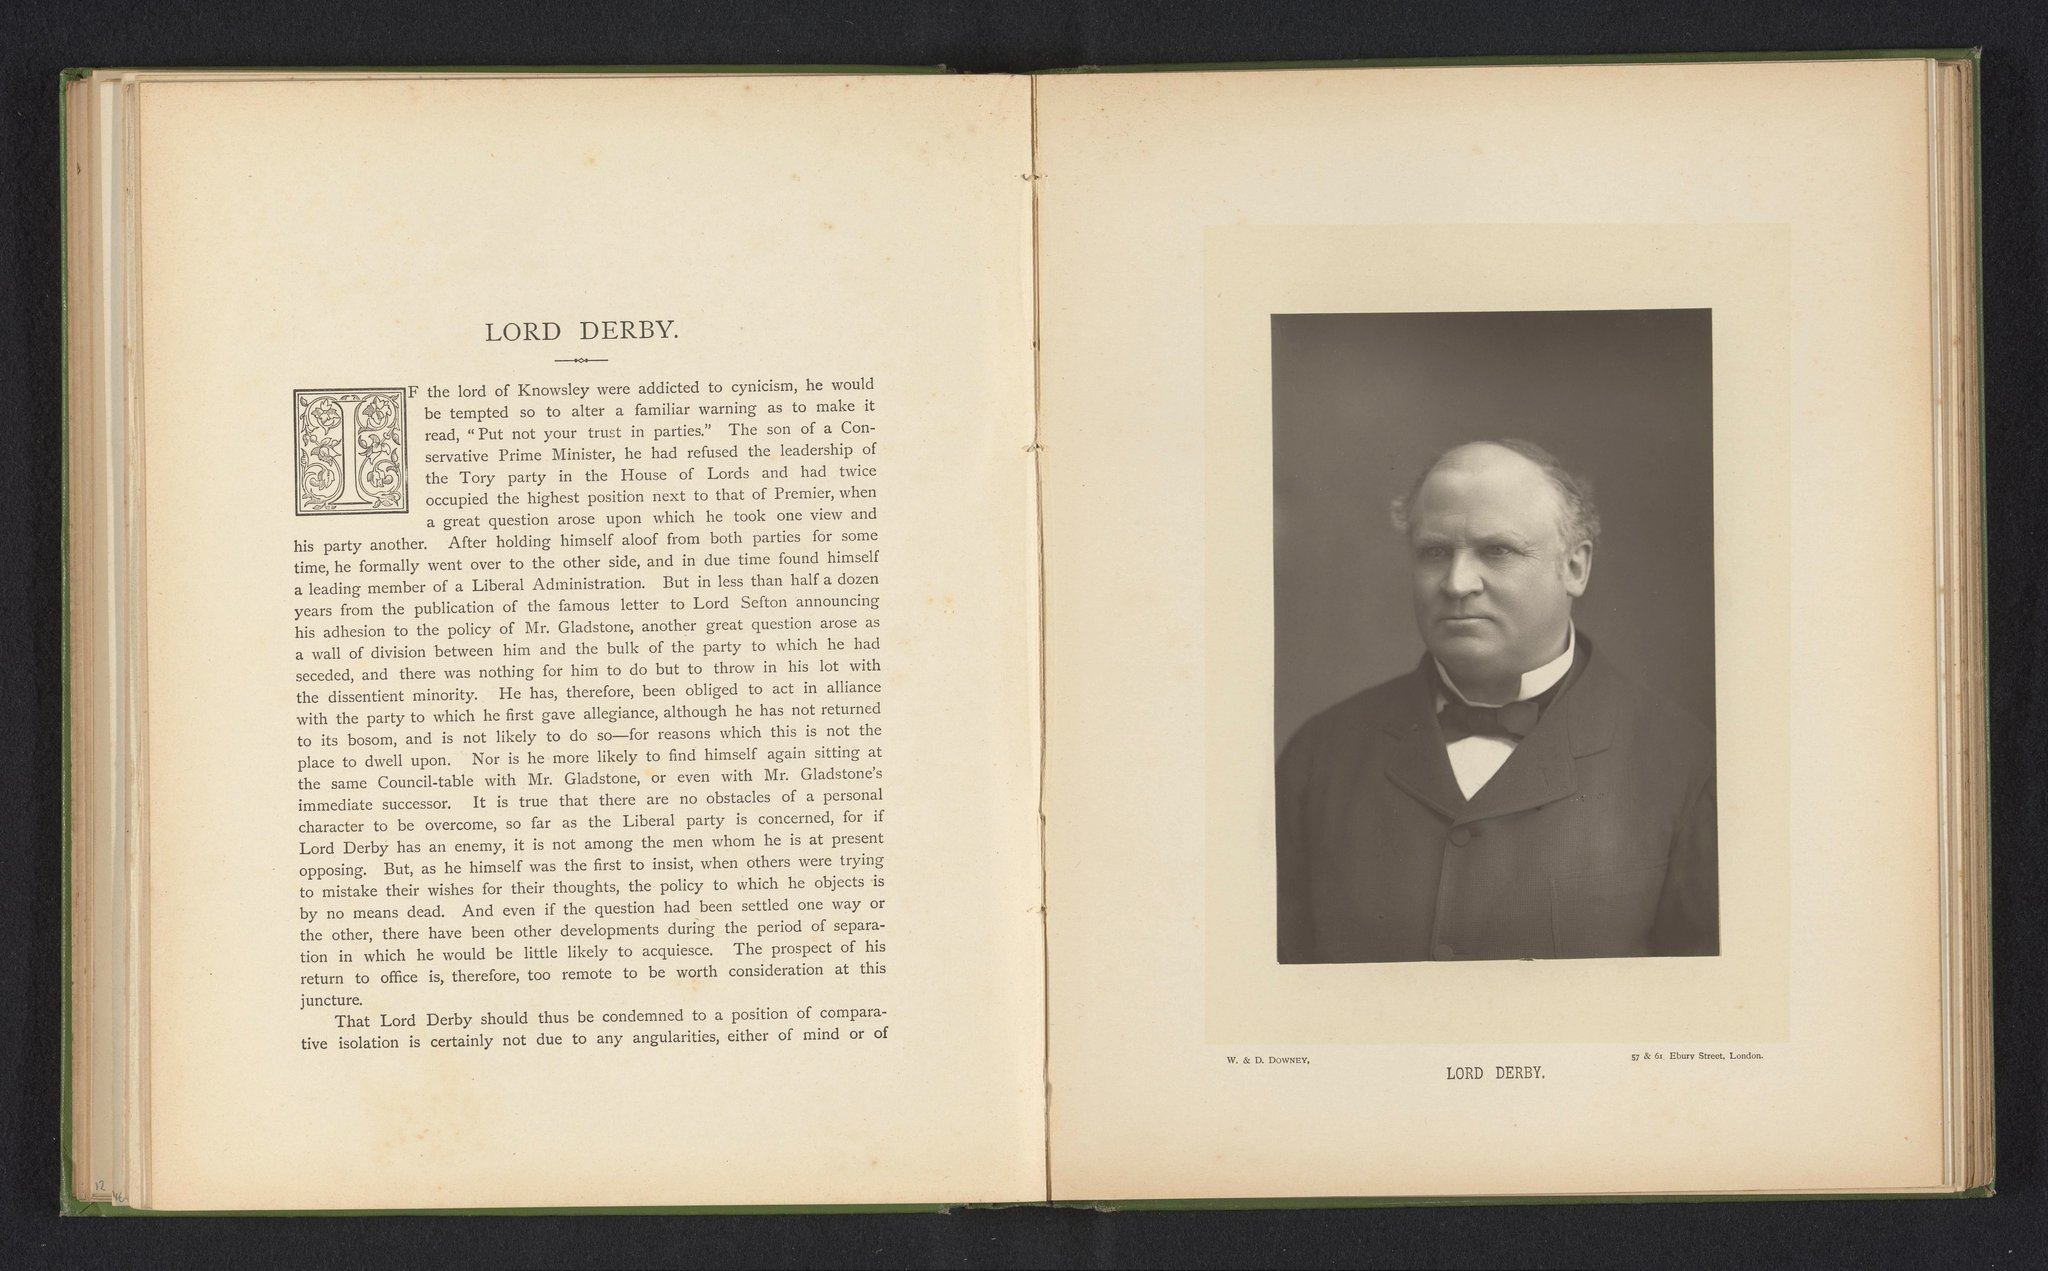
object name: page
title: Lord Derby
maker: Anonymous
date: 1884-1894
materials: paper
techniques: woodburytype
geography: london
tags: official; civil servant; functionary (in general)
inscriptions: inscription: ‘57 & 61, Elbury Street, London.’